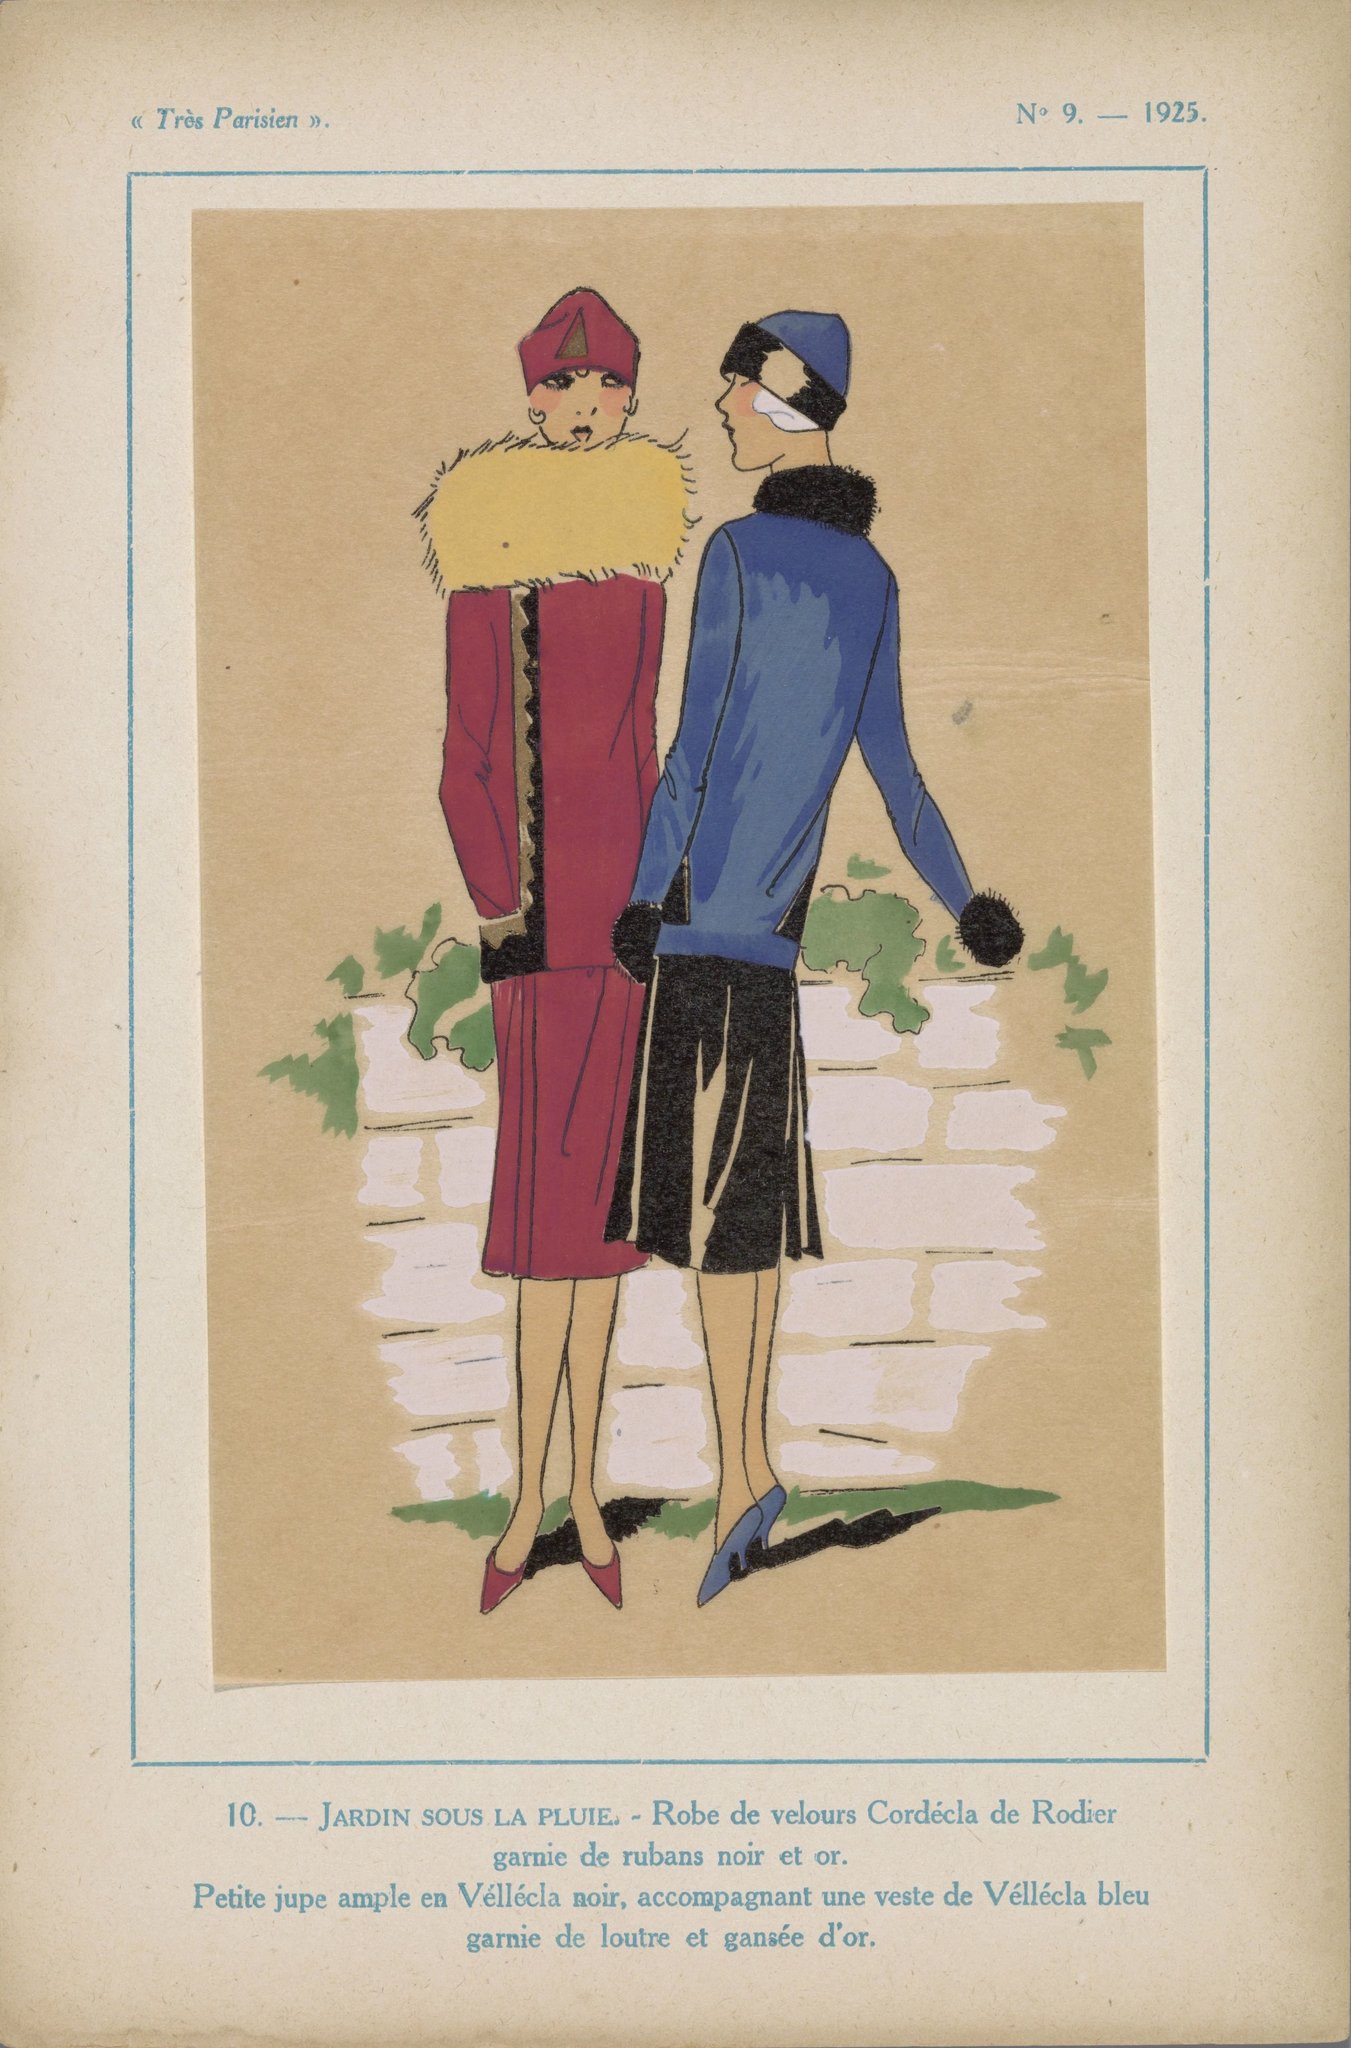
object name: fashion print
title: Très Parisien, 1925, No.9, Pl. 10.- JARDIN SOUS LA PLUIE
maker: g-p. joumard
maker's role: publisher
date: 1925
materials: paper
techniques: hand coloring, letterpress printing, lithography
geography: paris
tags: clothing for the upper part of the body (vest) (+ women's clothes), neck-gear: collar (+ women's clothes), fashion plates, skirt (+ women's clothes), dress, gown (+ women's clothes)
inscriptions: caption: ‘10. - JARDIN SOUS LA PLUIE. - Robe de velours Cordécla de Rodier garnie de rubans noir et or. Petite jupe ample en Véllécla noir, accompagnant une veste de Véllécla bleu garnie de loutre et gansée d' or.’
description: Japon van fluweel van Rodier. Rok en vest van 'Véllécla'. Prent uit het modetijdschrift Très Parisien...La Mode, Le Chic, L'Élégance (1920-1936)